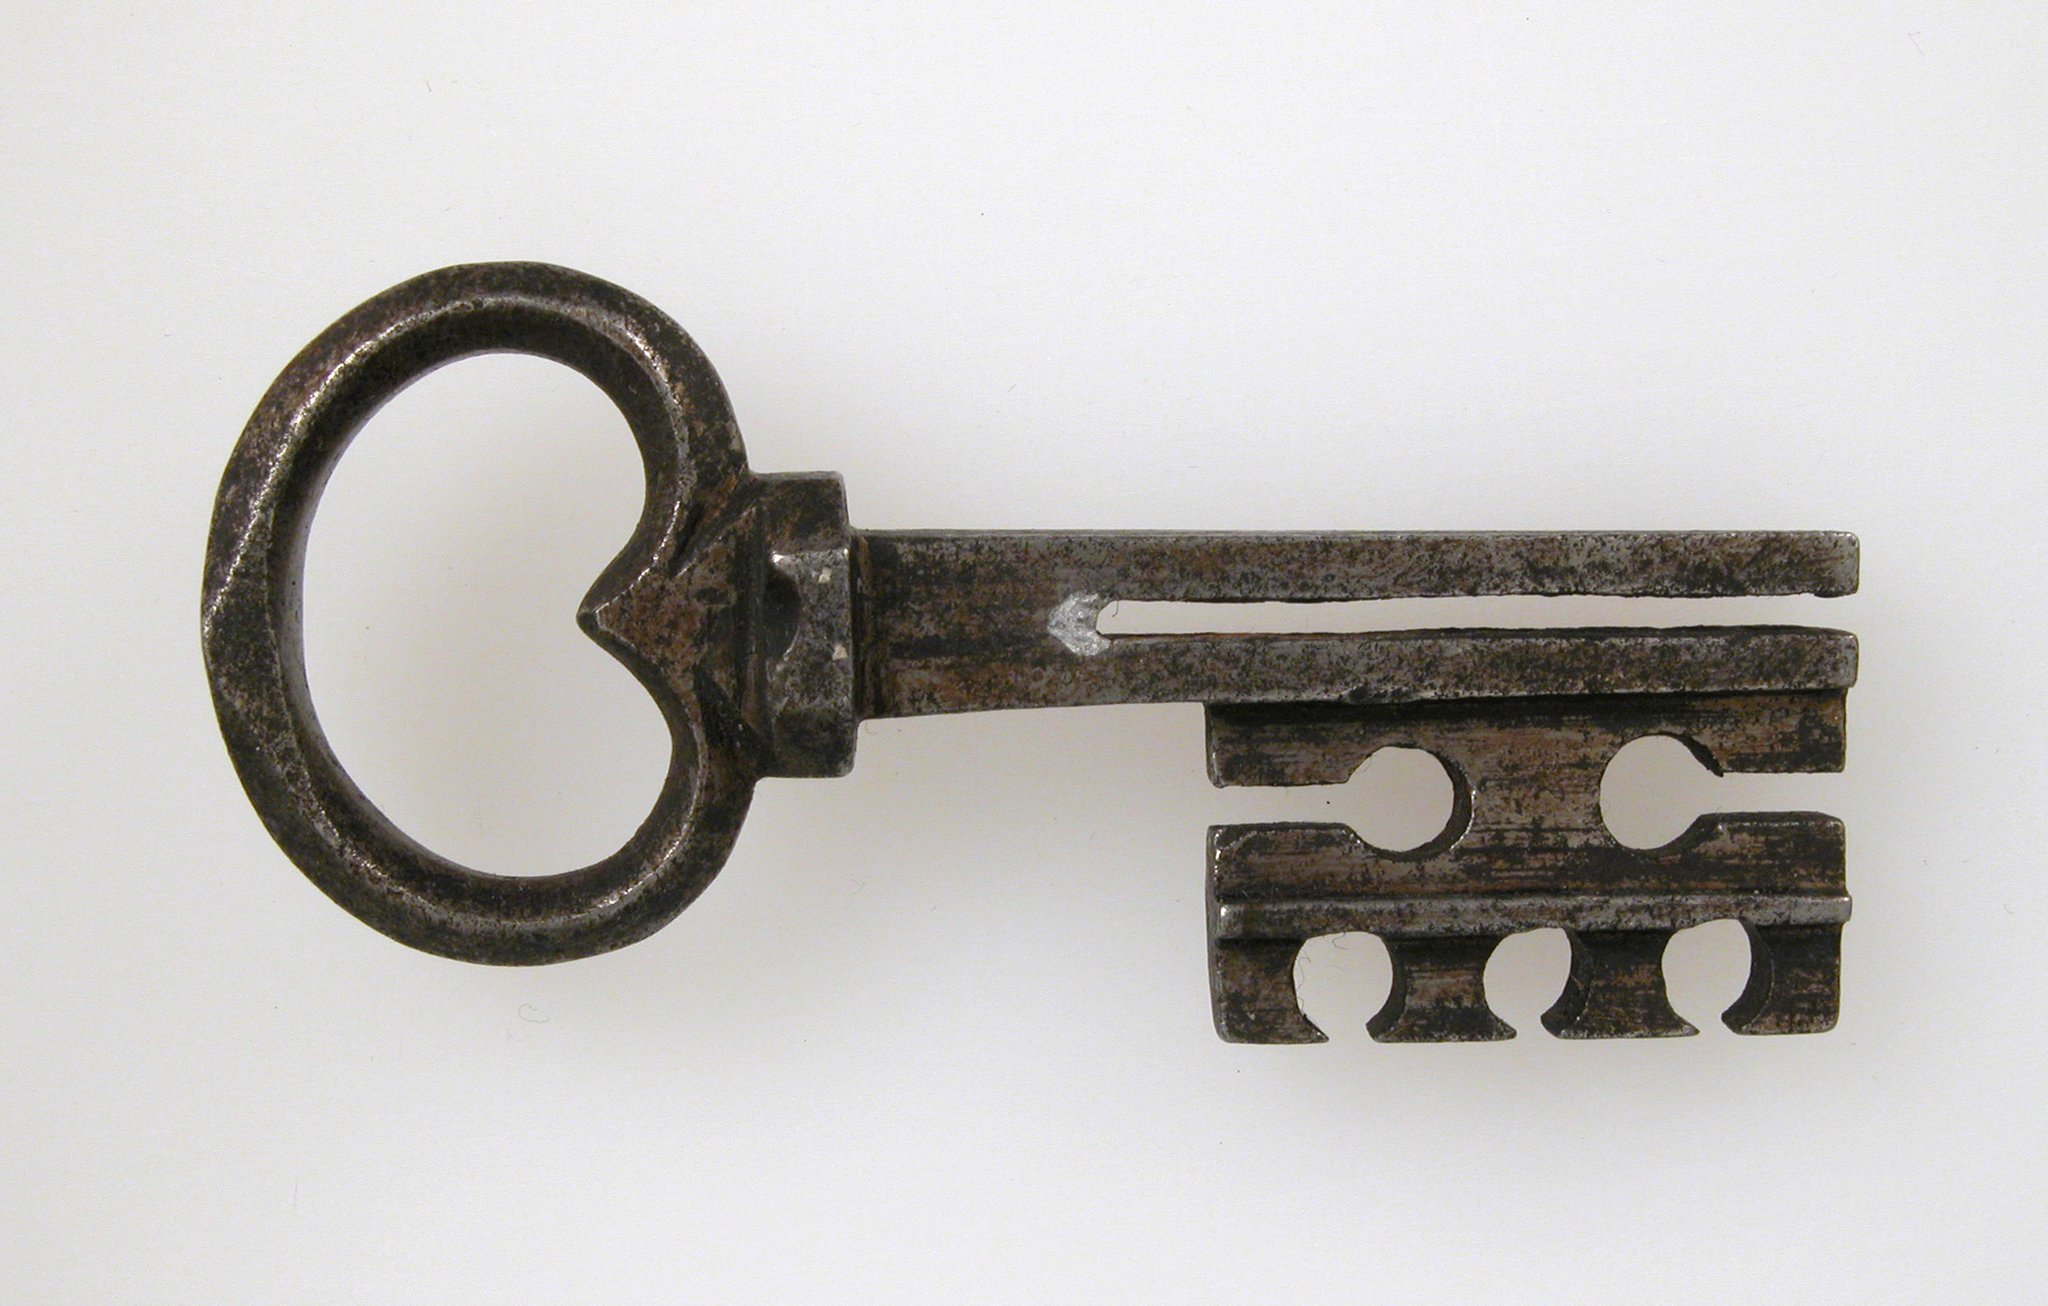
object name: key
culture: german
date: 1401-1500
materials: iron